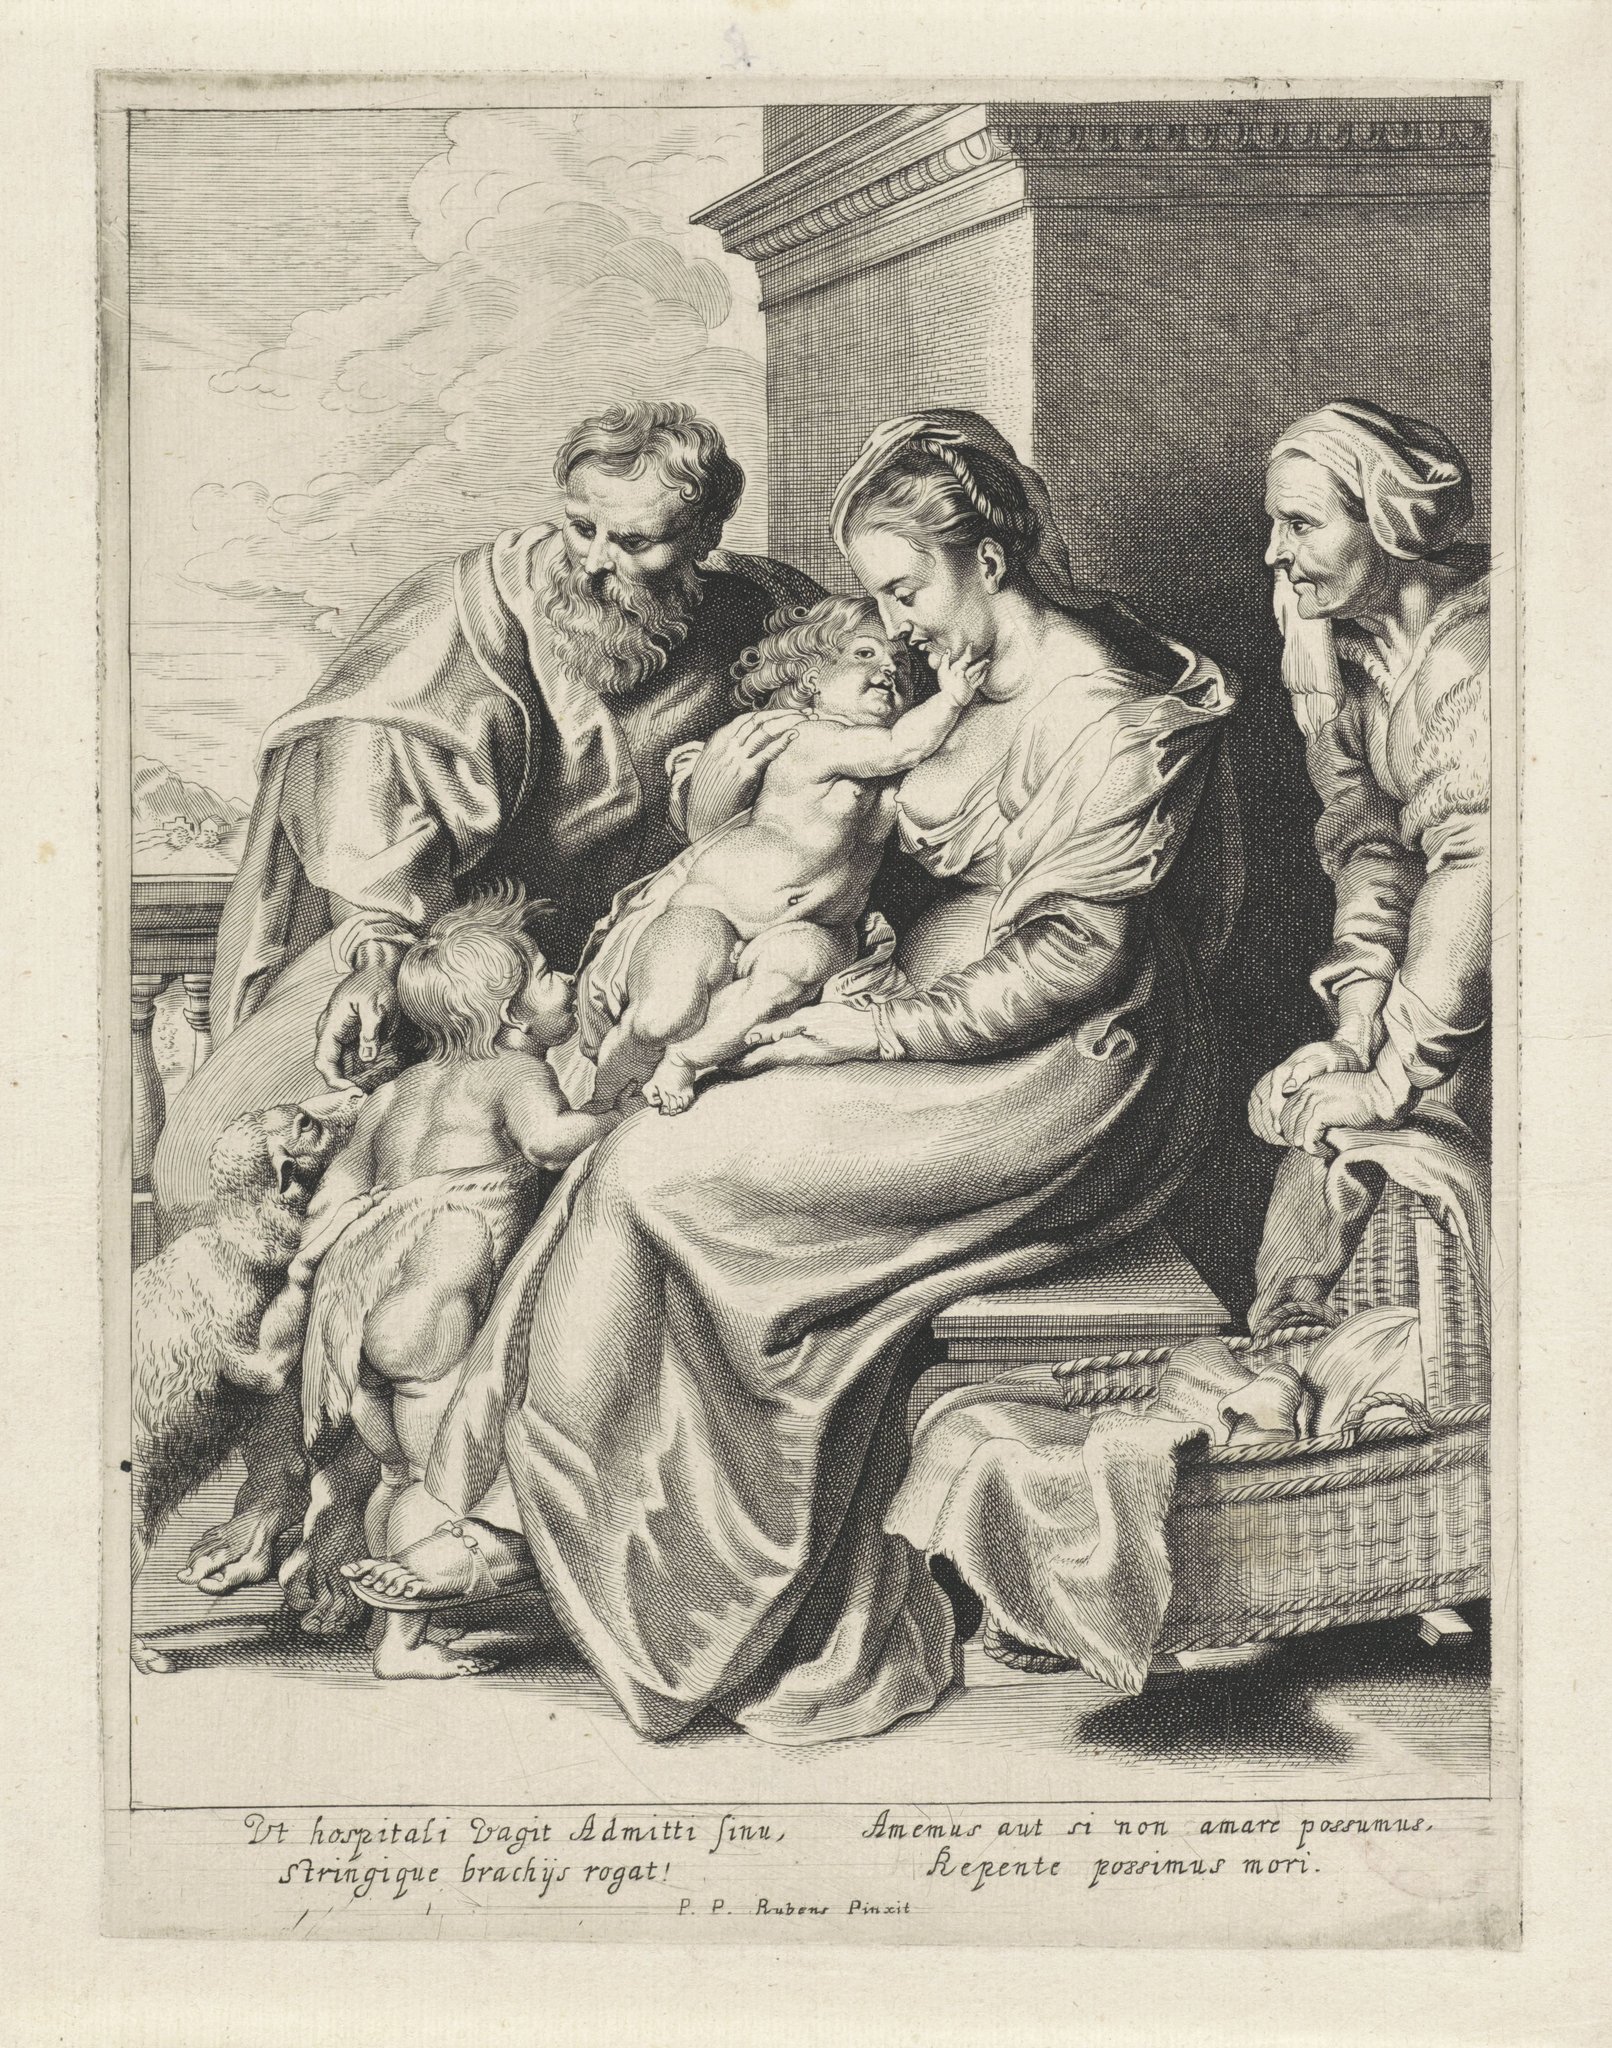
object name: print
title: Heilige Familie met Elisabet en Johannes de Doper als kind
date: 1620-1670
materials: paper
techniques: engraving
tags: holy family with john the baptist, elisabeth present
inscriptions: collector's mark: Lugt 240